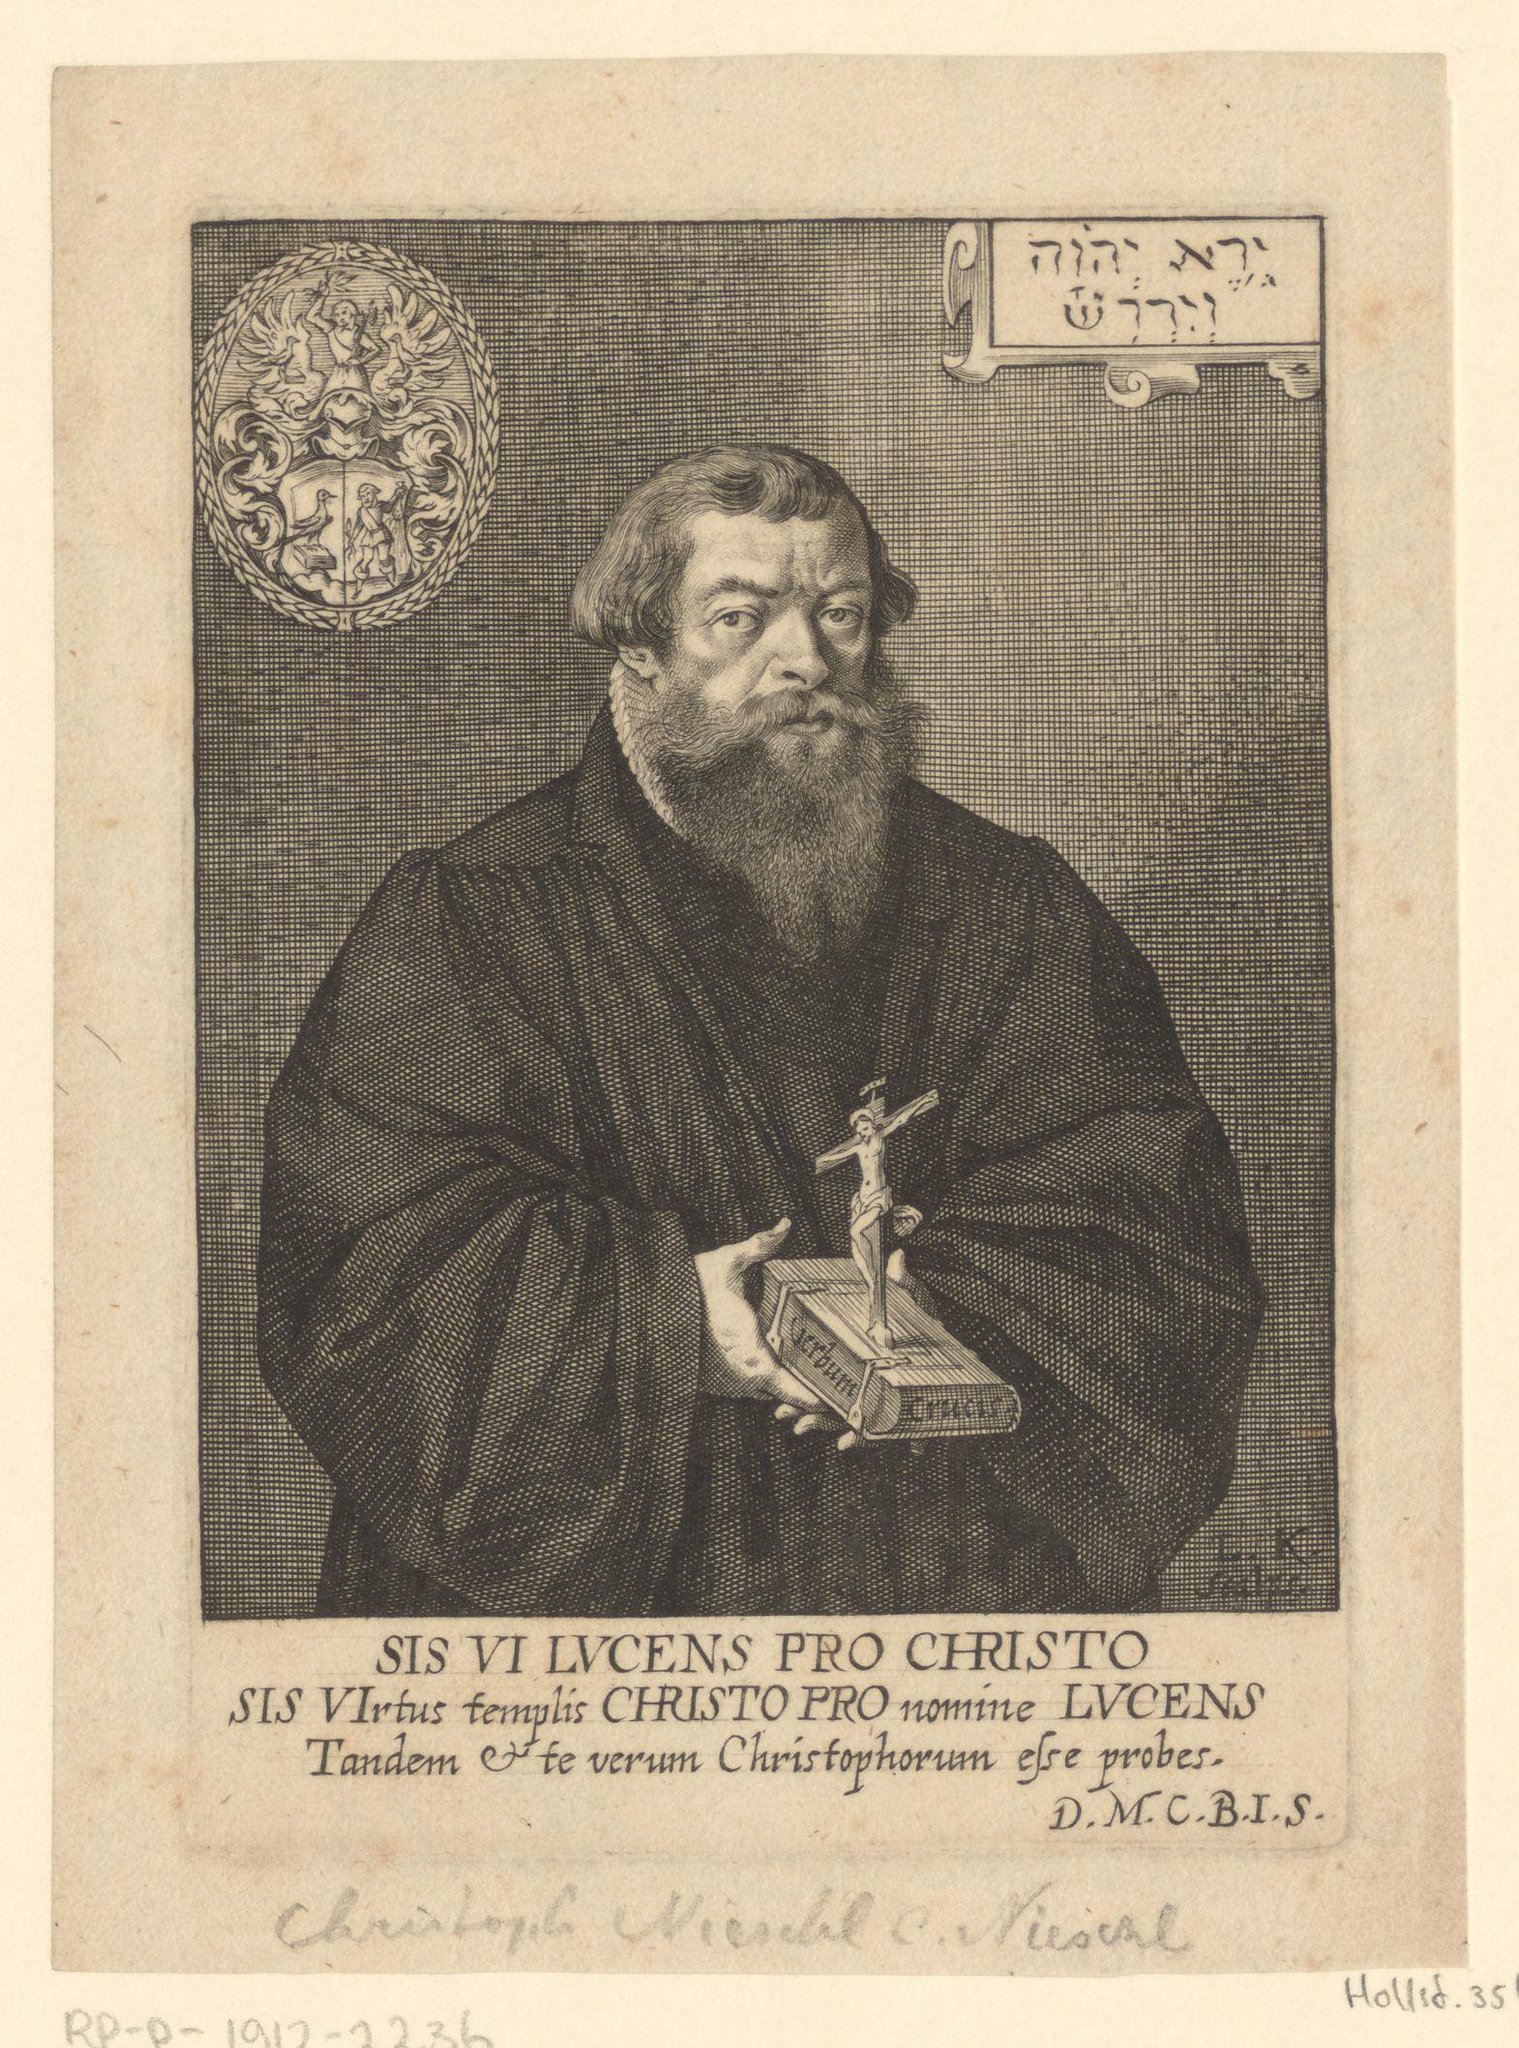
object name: print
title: Portret van Christoph Nieschl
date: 1619-1637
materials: paper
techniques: engraving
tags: augsburg, theologian, historical persons, crucifix ~ personal devotion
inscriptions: collector's mark: Lugt 2228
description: Tekst in het Latijn in de ondermarge en tekst in het Hebreeuws in het kader bovenaan.